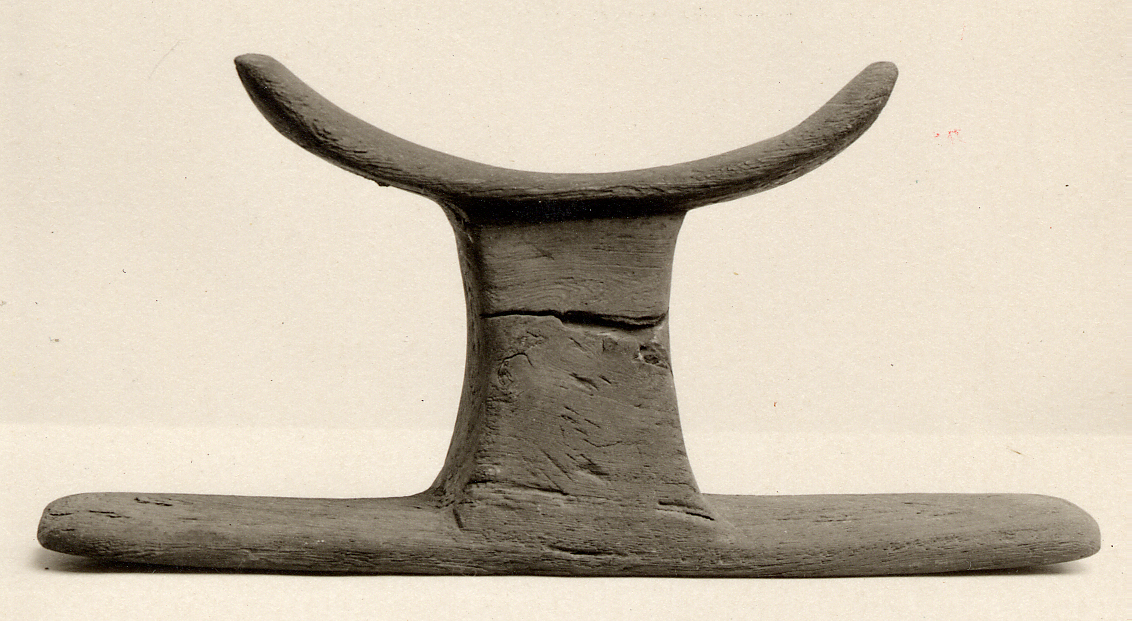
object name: headrest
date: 2040-1802 BCE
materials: wood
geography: egypt